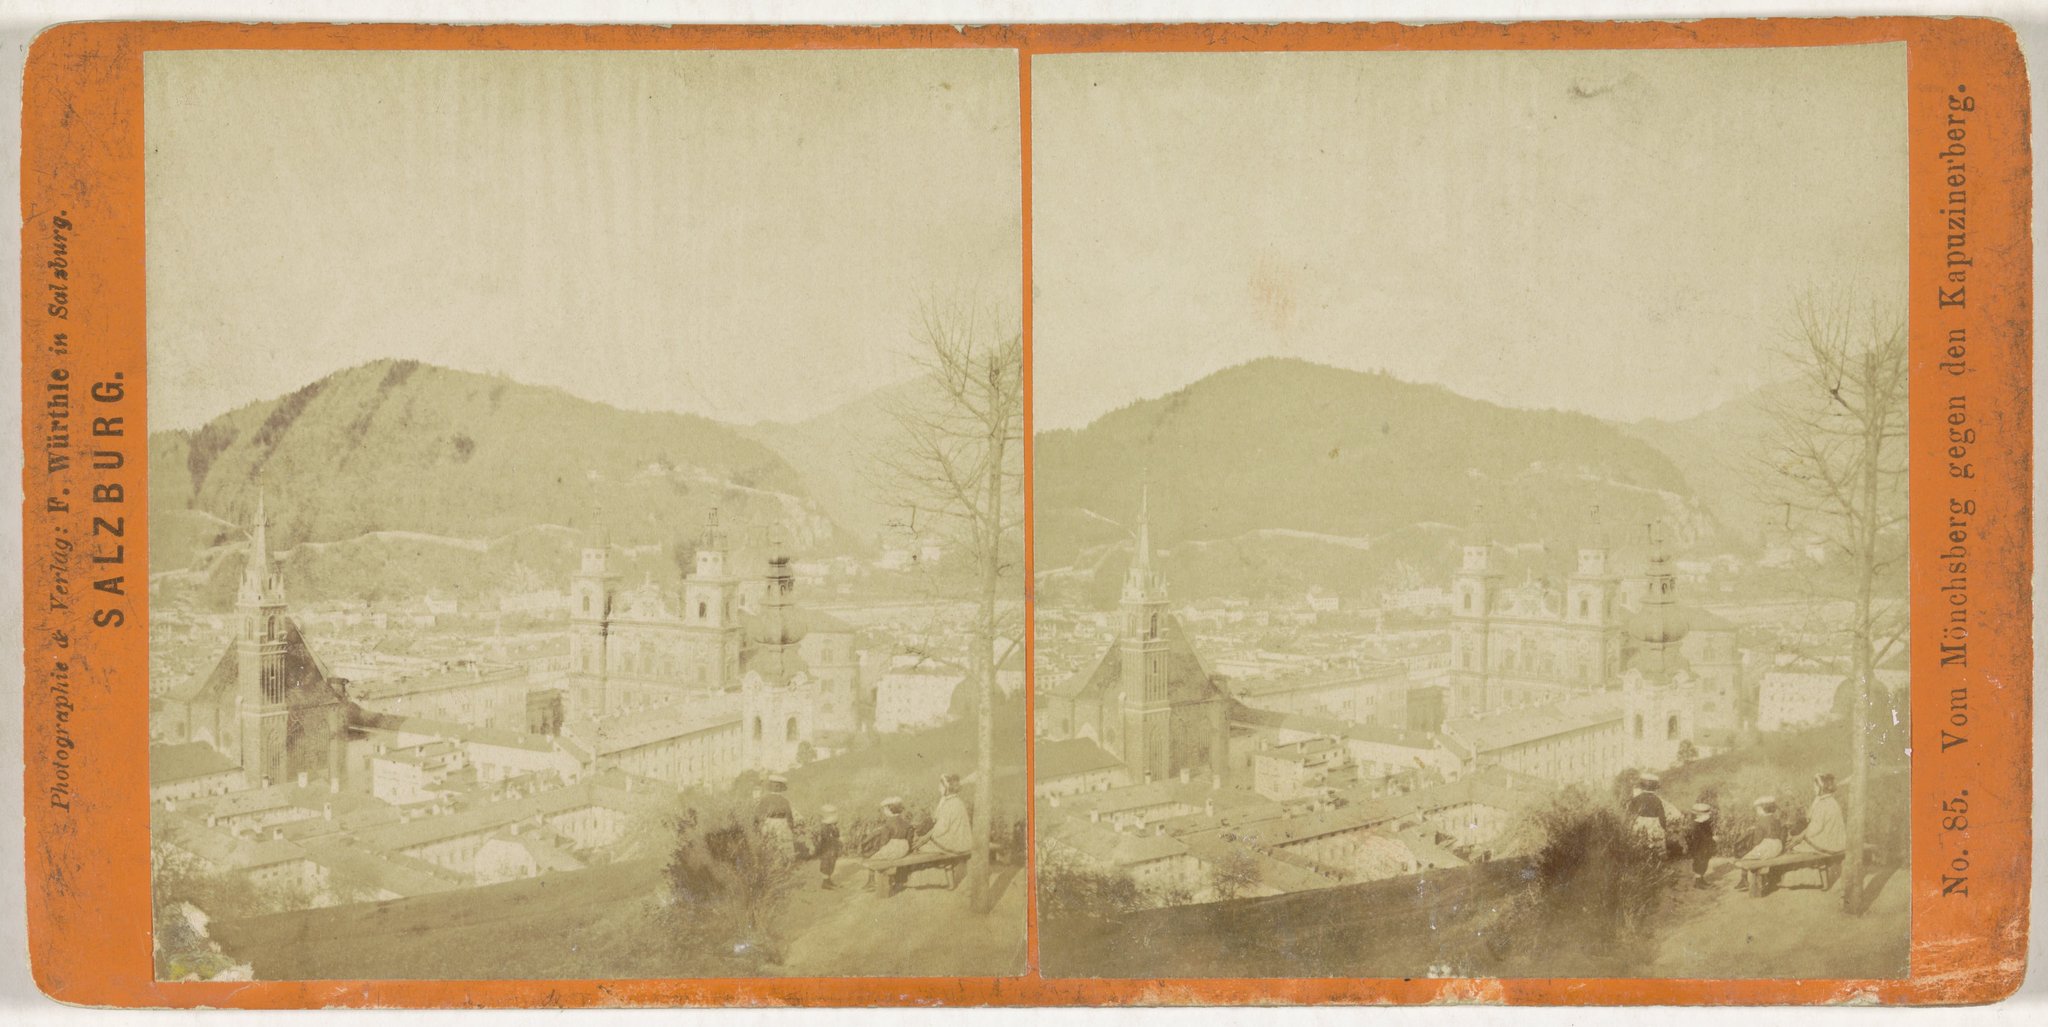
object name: stereograph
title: Gezicht op Salzburg, gezien vanaf de Mönchsberg richting de Kapuzinerberg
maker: carl friedrich würthle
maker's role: print maker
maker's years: 1820-1902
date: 1874-1875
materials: cardboard, paper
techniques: albumen print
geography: salzburg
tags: city-view in general; 'veduta'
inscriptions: number: ‘No. 85’